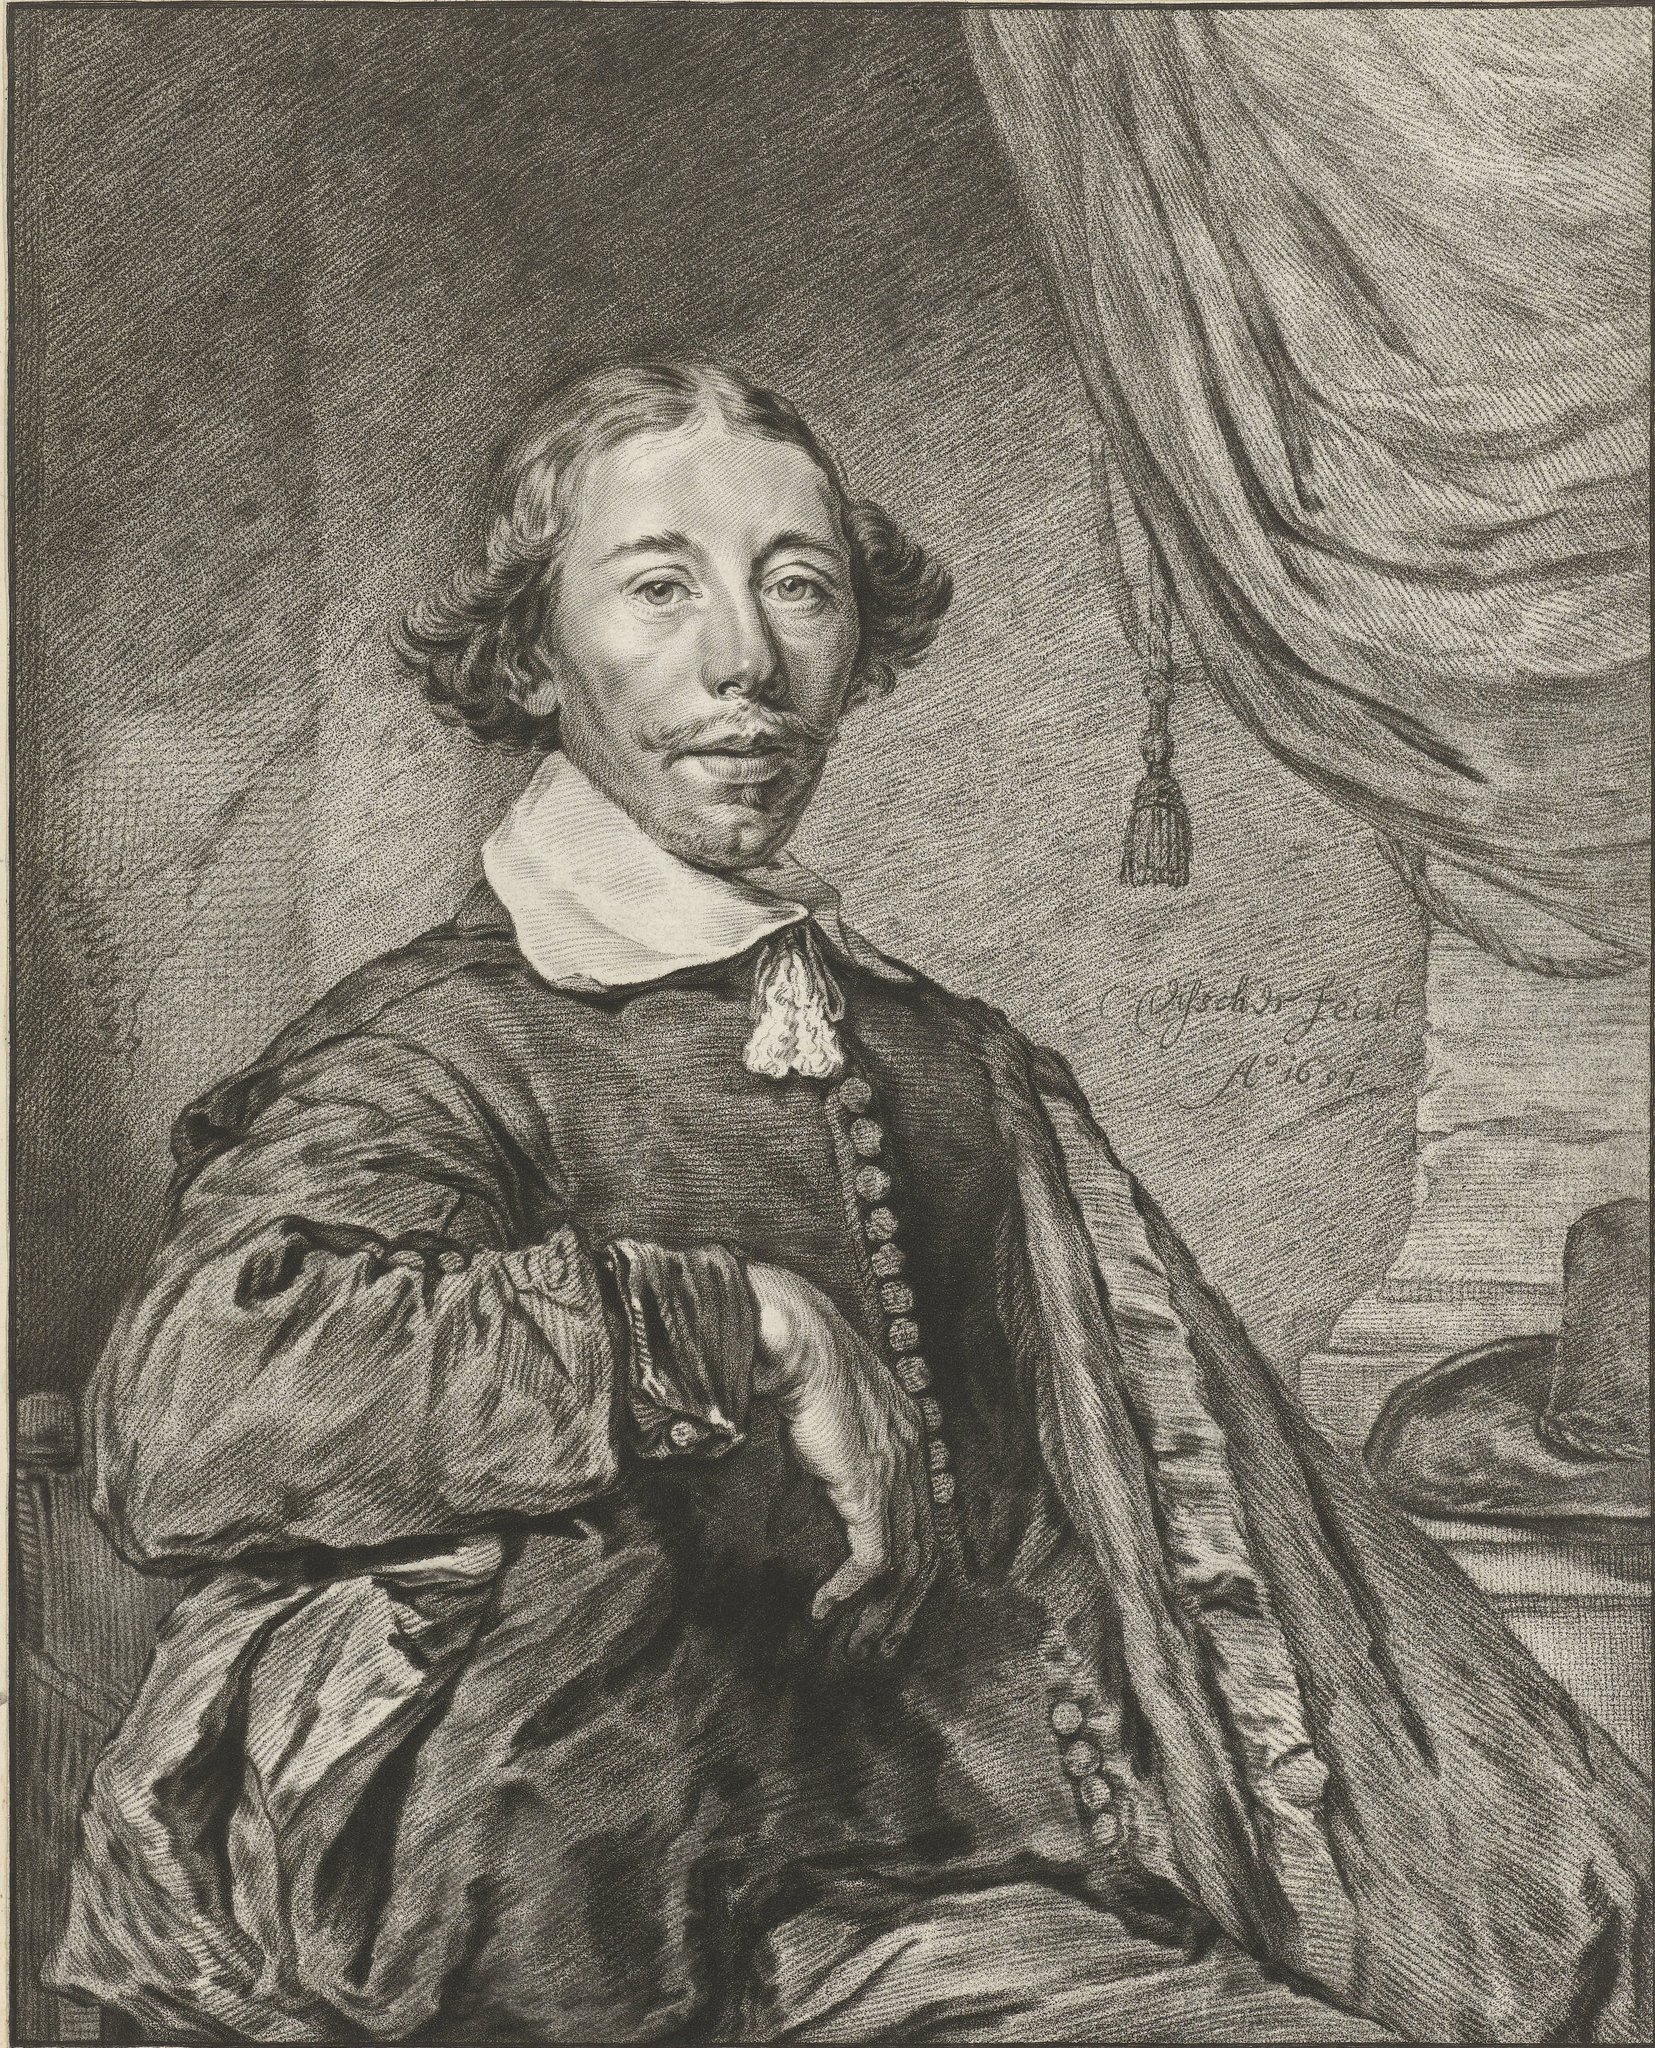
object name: print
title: Portret van een man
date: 1771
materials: paper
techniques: printmaking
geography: amsterdam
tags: adult man, head-gear: hat (+ men's clothes)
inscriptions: collector's mark: ‘RIJKS / MUSM’ Lugt, inscription: ‘C Visscher del 1651 Ploos van AMstel J.Corn 1771’, collector's mark: Lugt 2725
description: Portret van een man, zittend voor een gordijn. Zijn hoed ligt op een tafel.